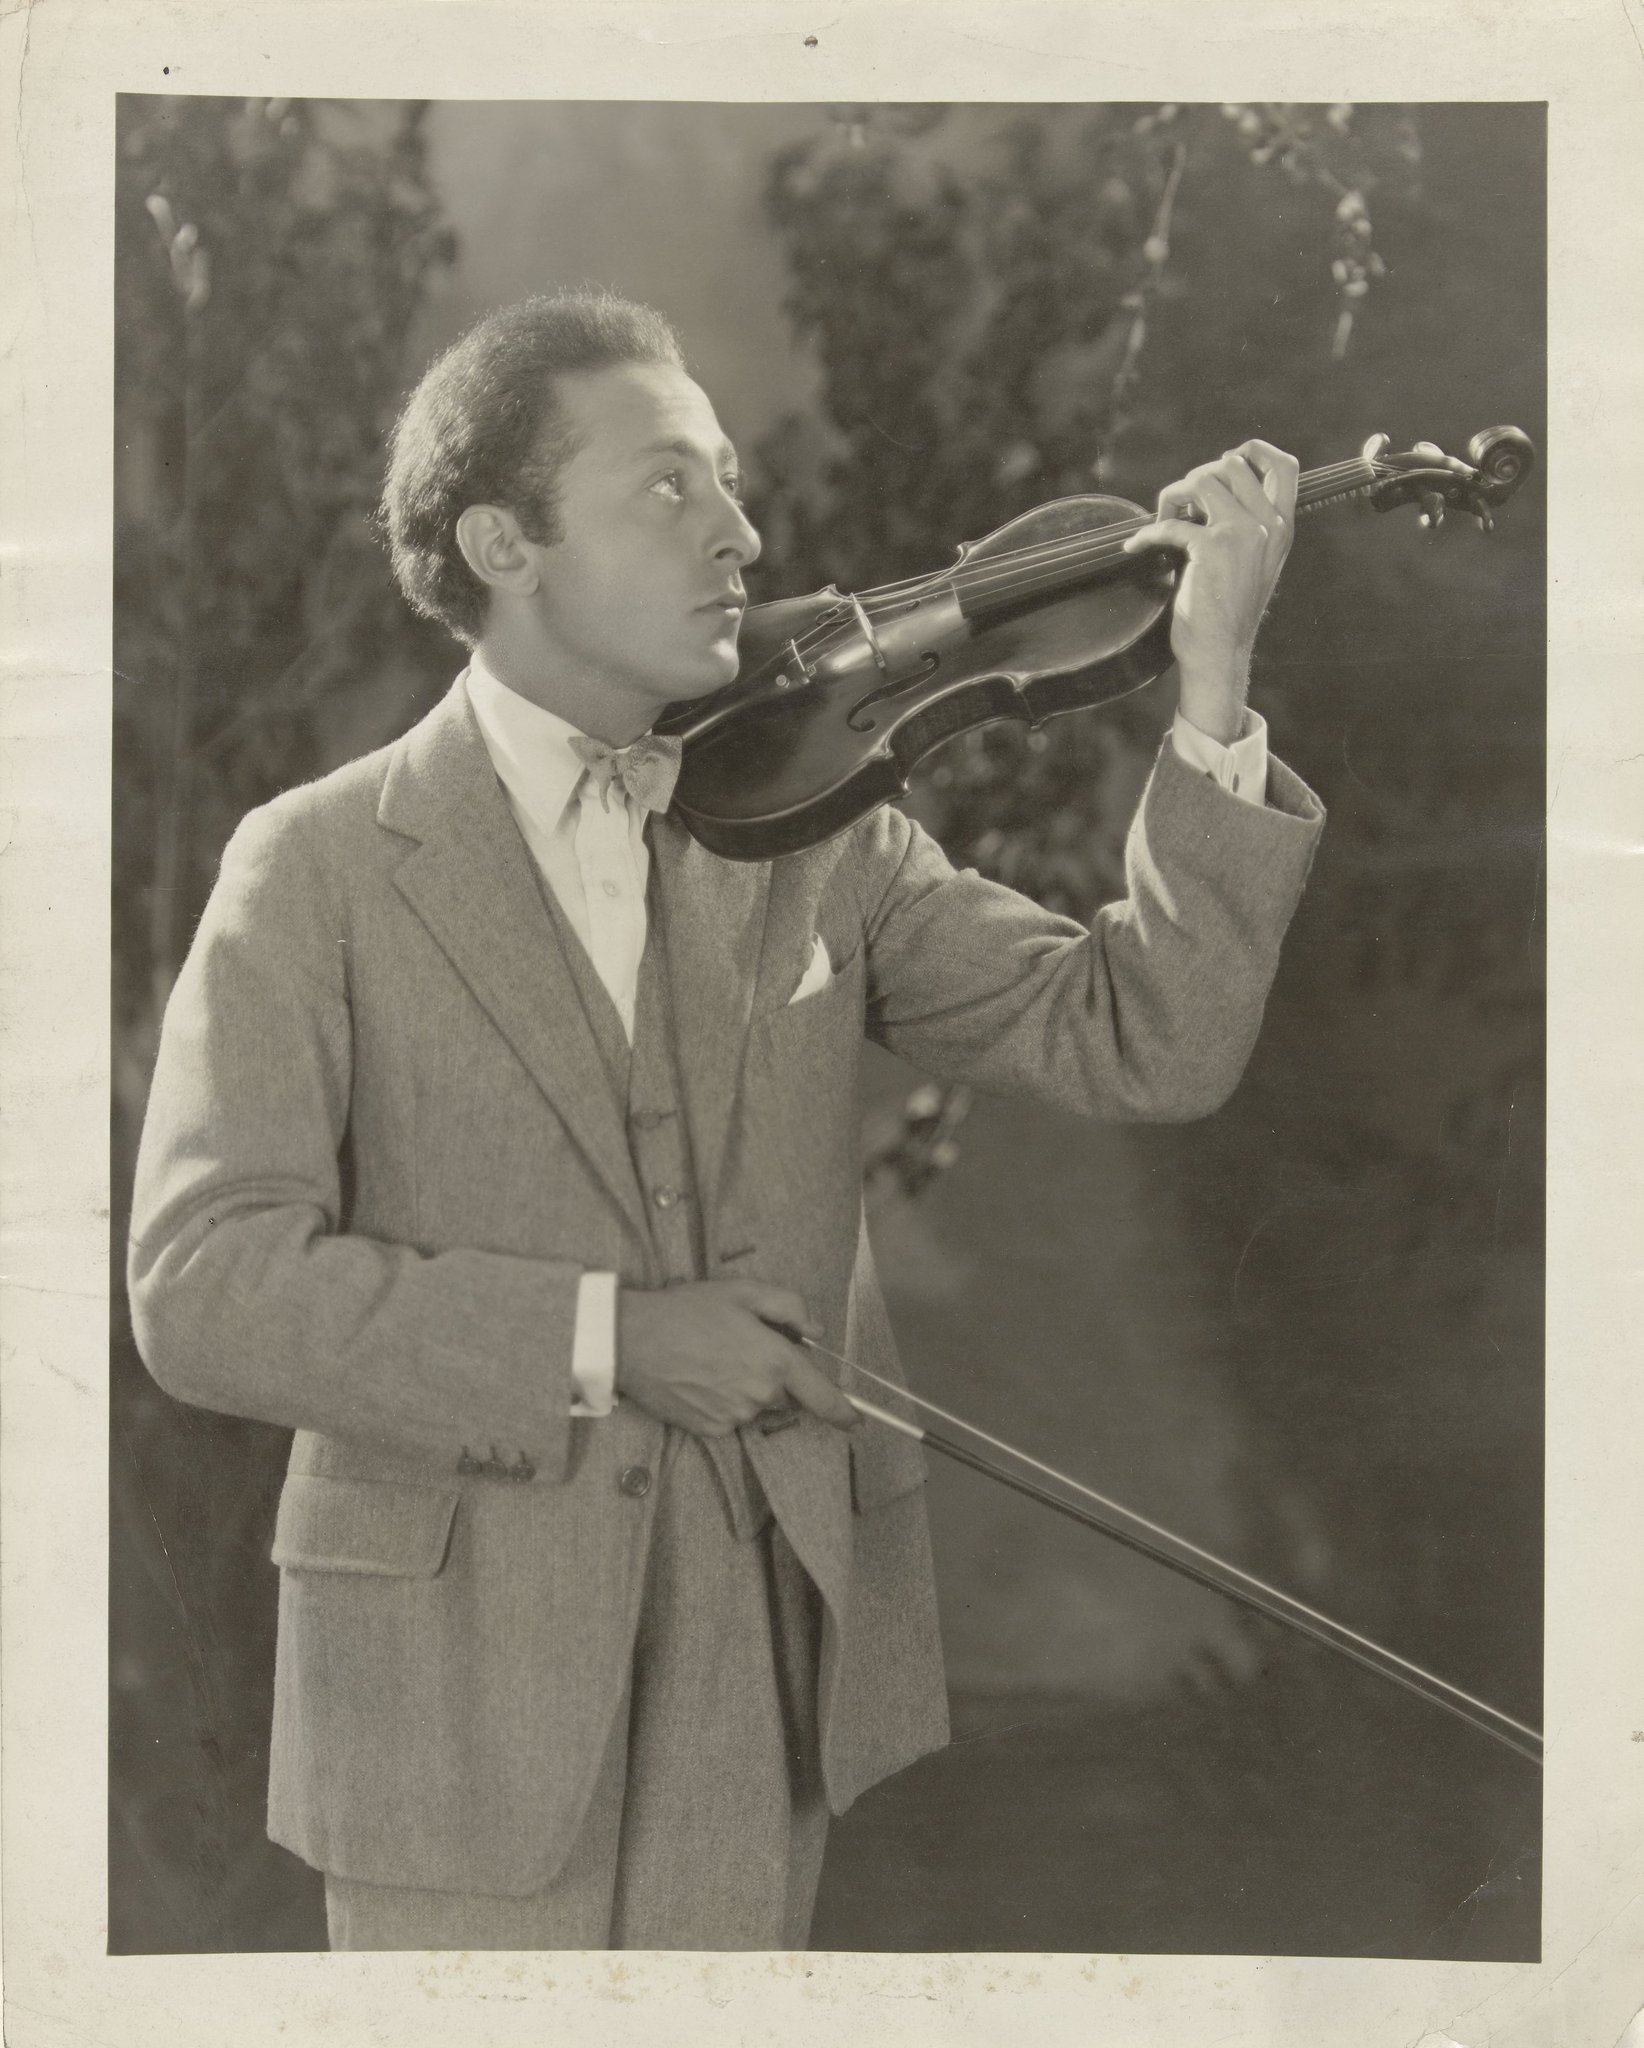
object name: photograph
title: Portret van violist Jascha Heifetz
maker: Anonymous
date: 1900-1938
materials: photographic support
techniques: gelatin silver print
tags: historical persons, portrait of a musician